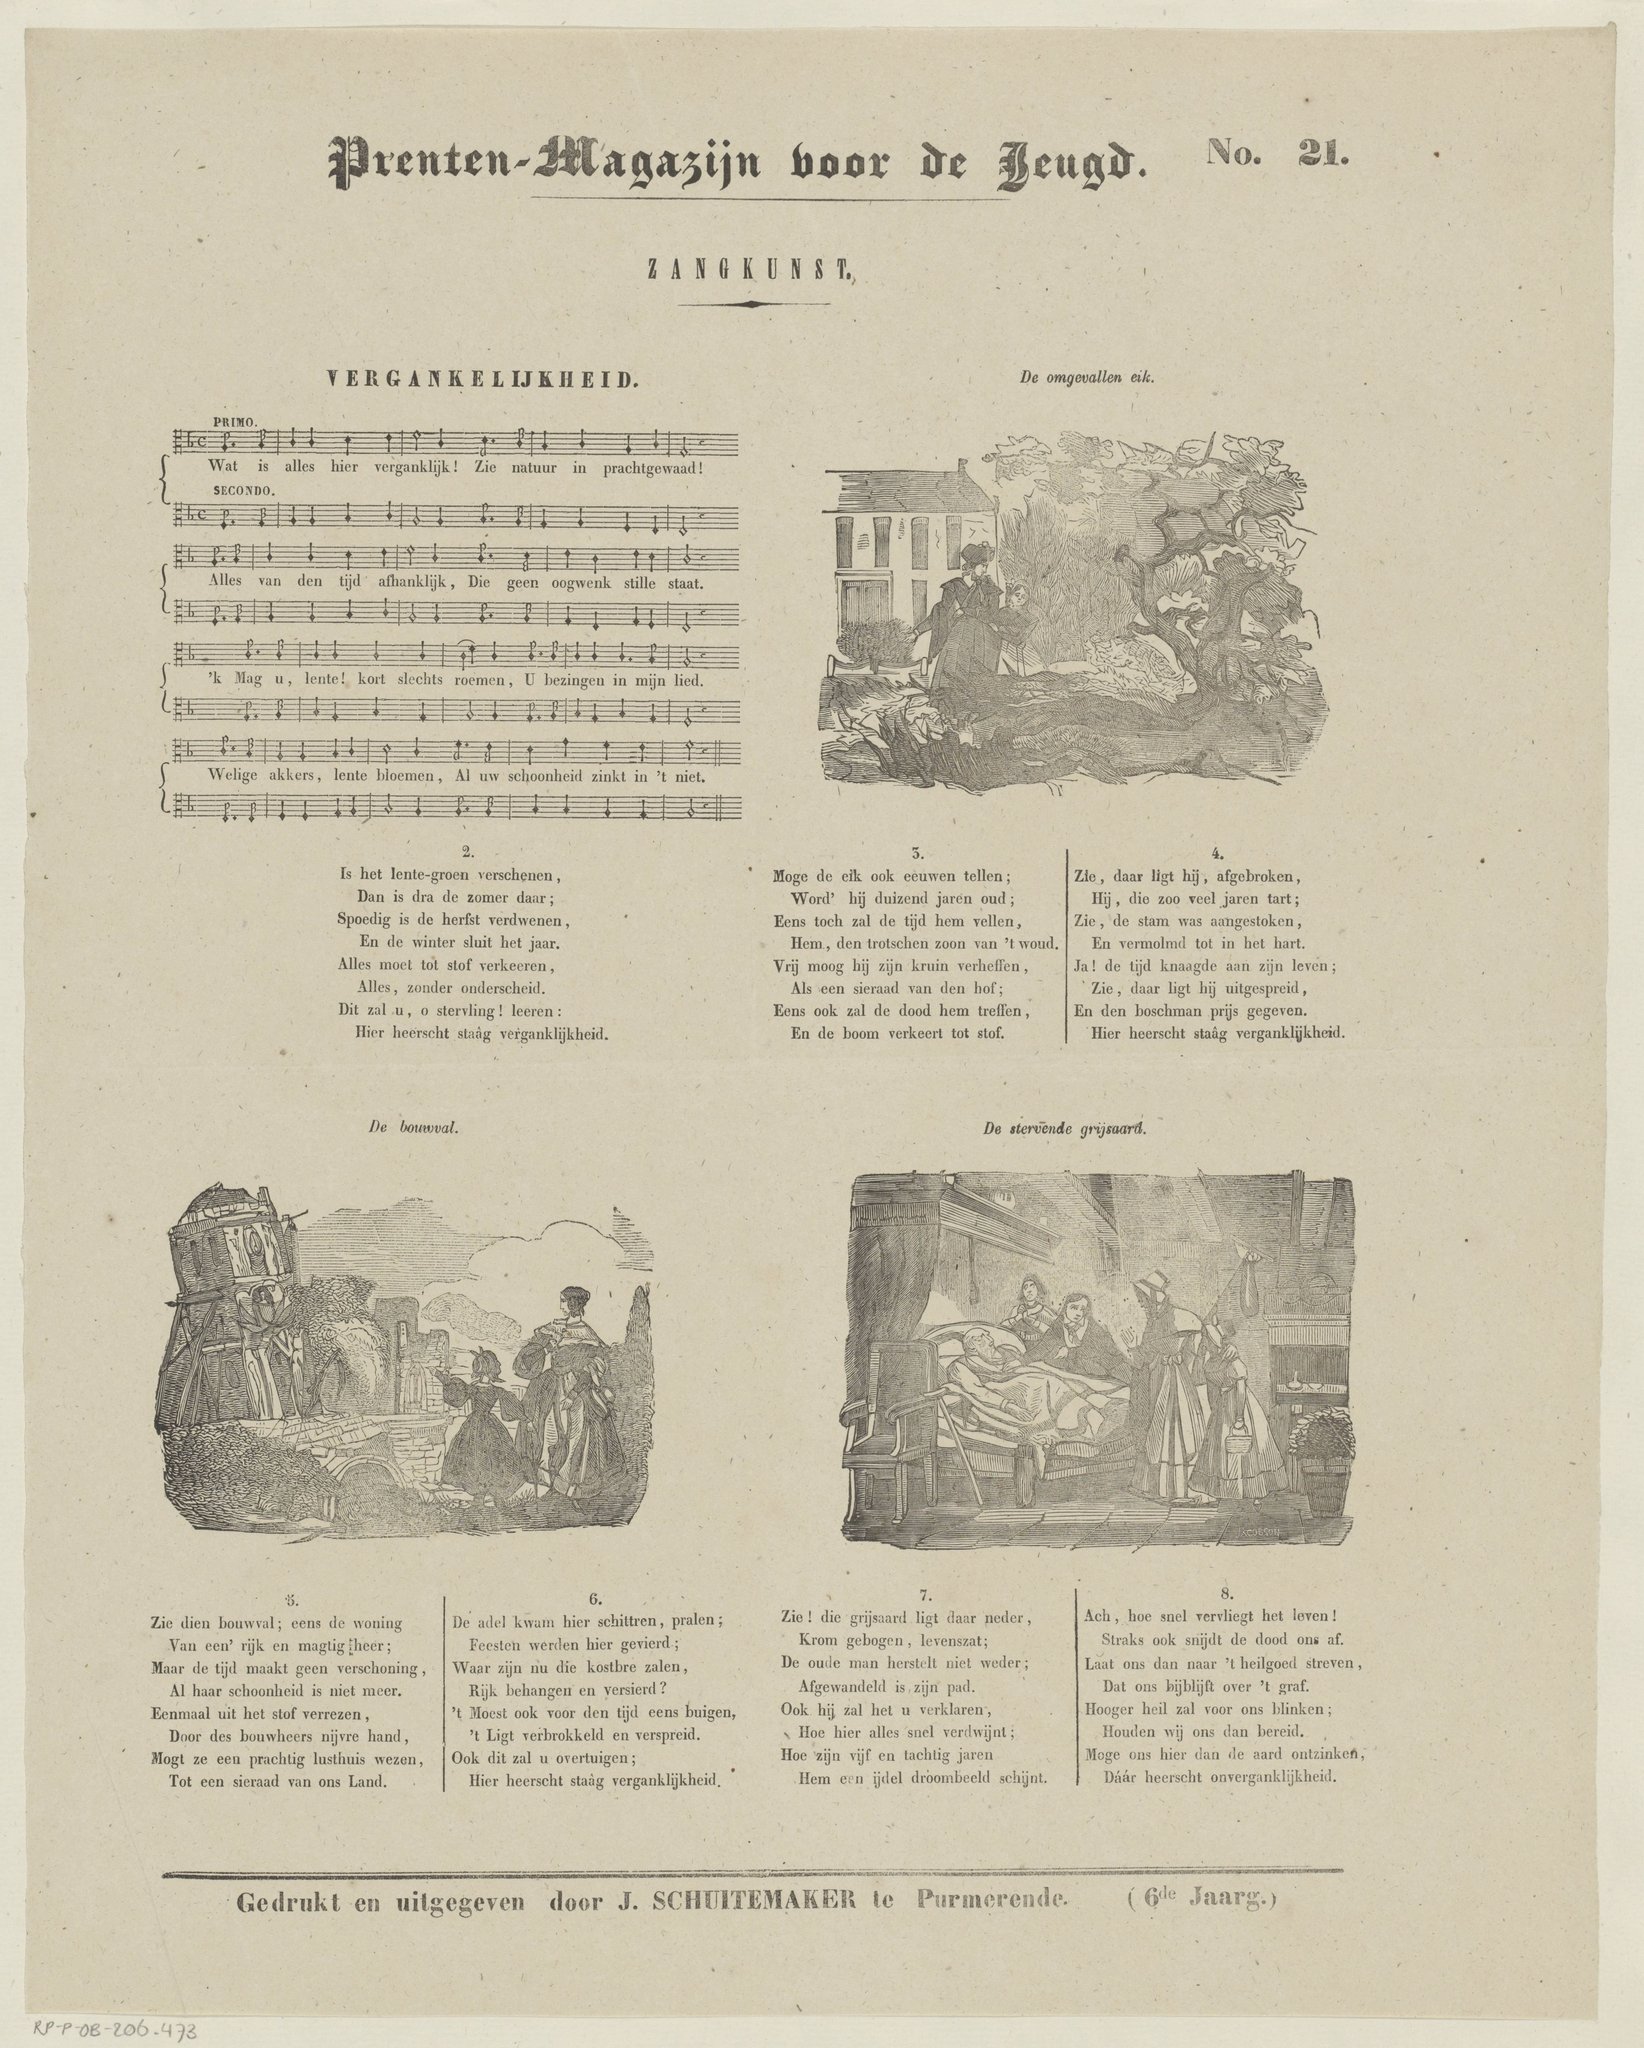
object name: print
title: Vergankelijkheid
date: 1847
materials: paper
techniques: letterpress printing, engraving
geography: netherlands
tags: trees: oak, landscape with ruins, old man, dying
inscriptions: collector's mark: Lugt 2760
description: Blad met 3 voorstellingen en een stuk bladmuziek met een lied over vergankelijkheid. Boven elke voorstelling een titel en onder elke voorstelling coupletten van het lied. Genummerd rechtsboven: No. 21.